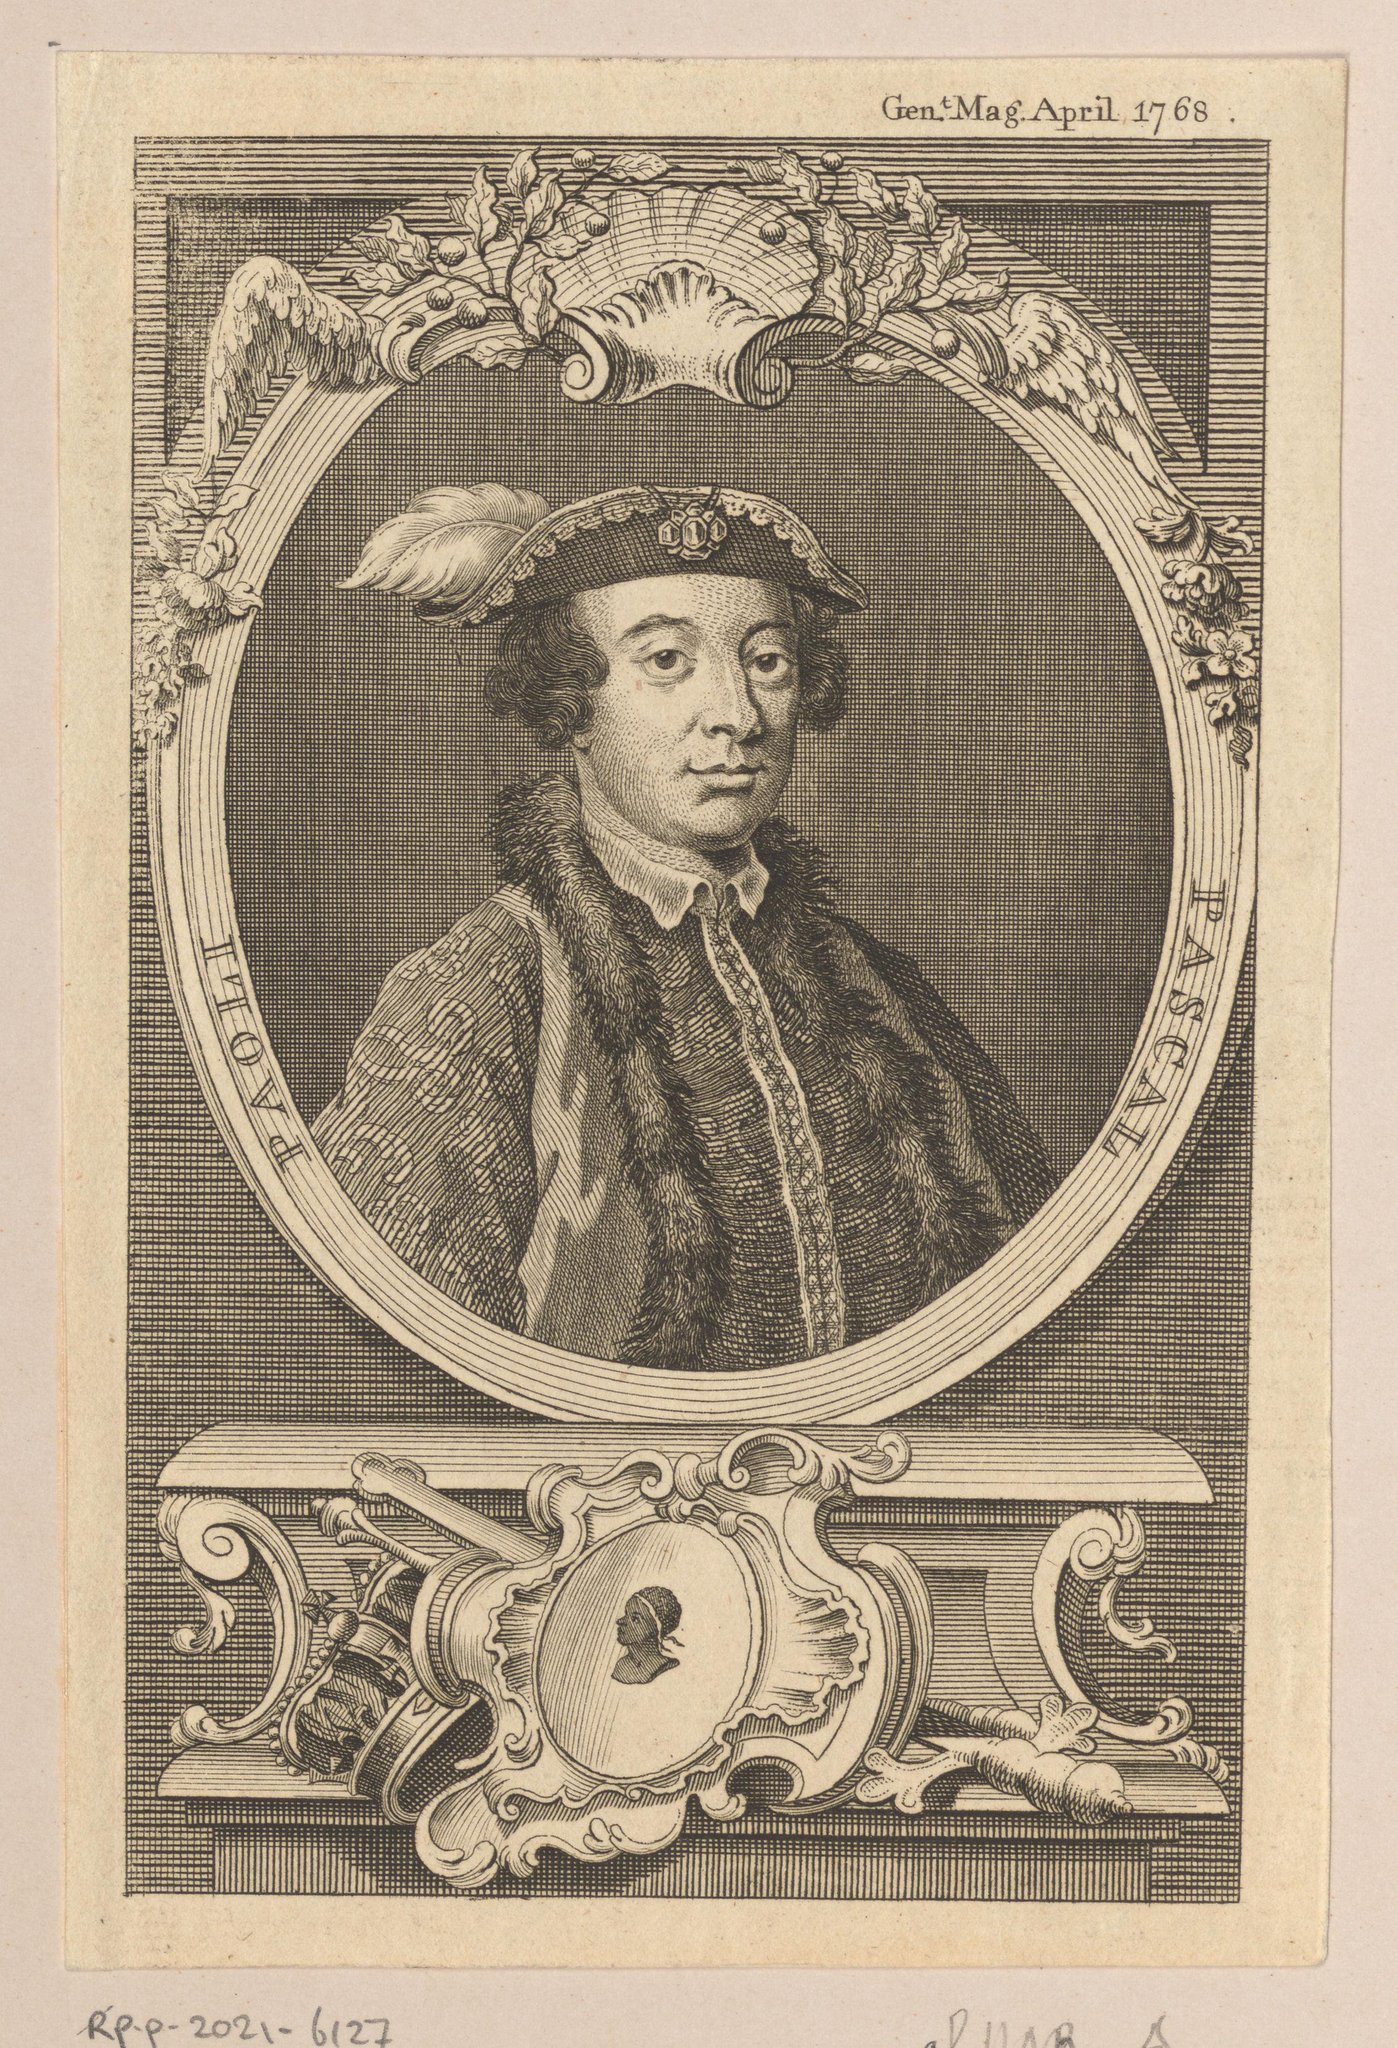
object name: print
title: Portret van Pasquale Paoli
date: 1768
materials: paper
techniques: engraving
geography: london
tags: adult man, historical persons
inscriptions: date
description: Prent uit: The Gentleman's Magazine 4 (1768), april 1768.